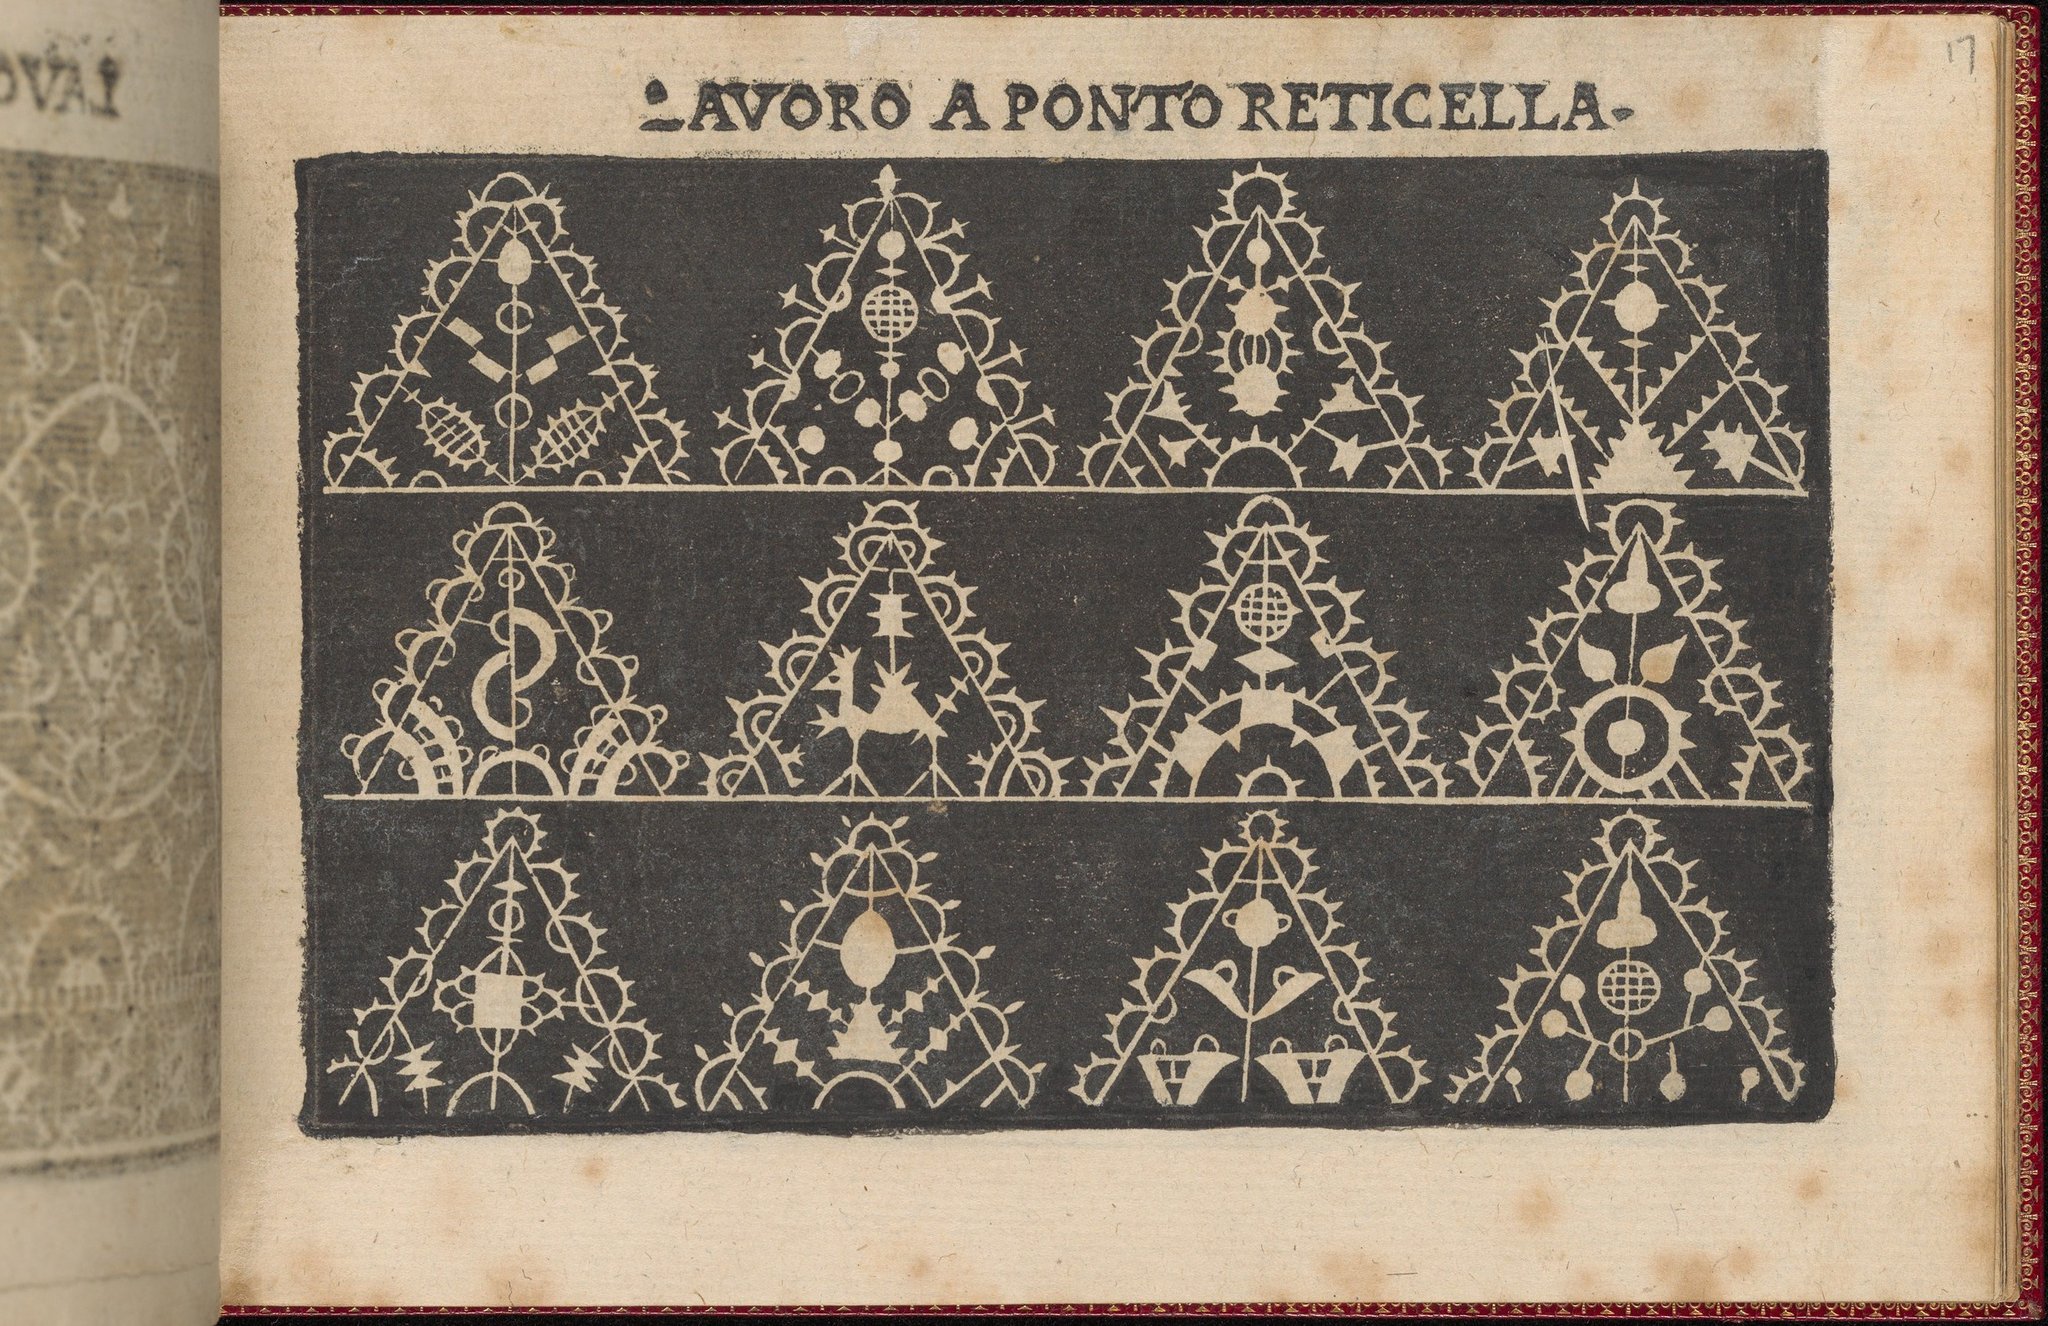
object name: book print ornament architecture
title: Pretiosa Gemma delle virtuose donne, page 19 (recto)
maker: isabella catanea parasole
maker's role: author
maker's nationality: italian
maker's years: 1565-1625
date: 1600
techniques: woodcut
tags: ornament